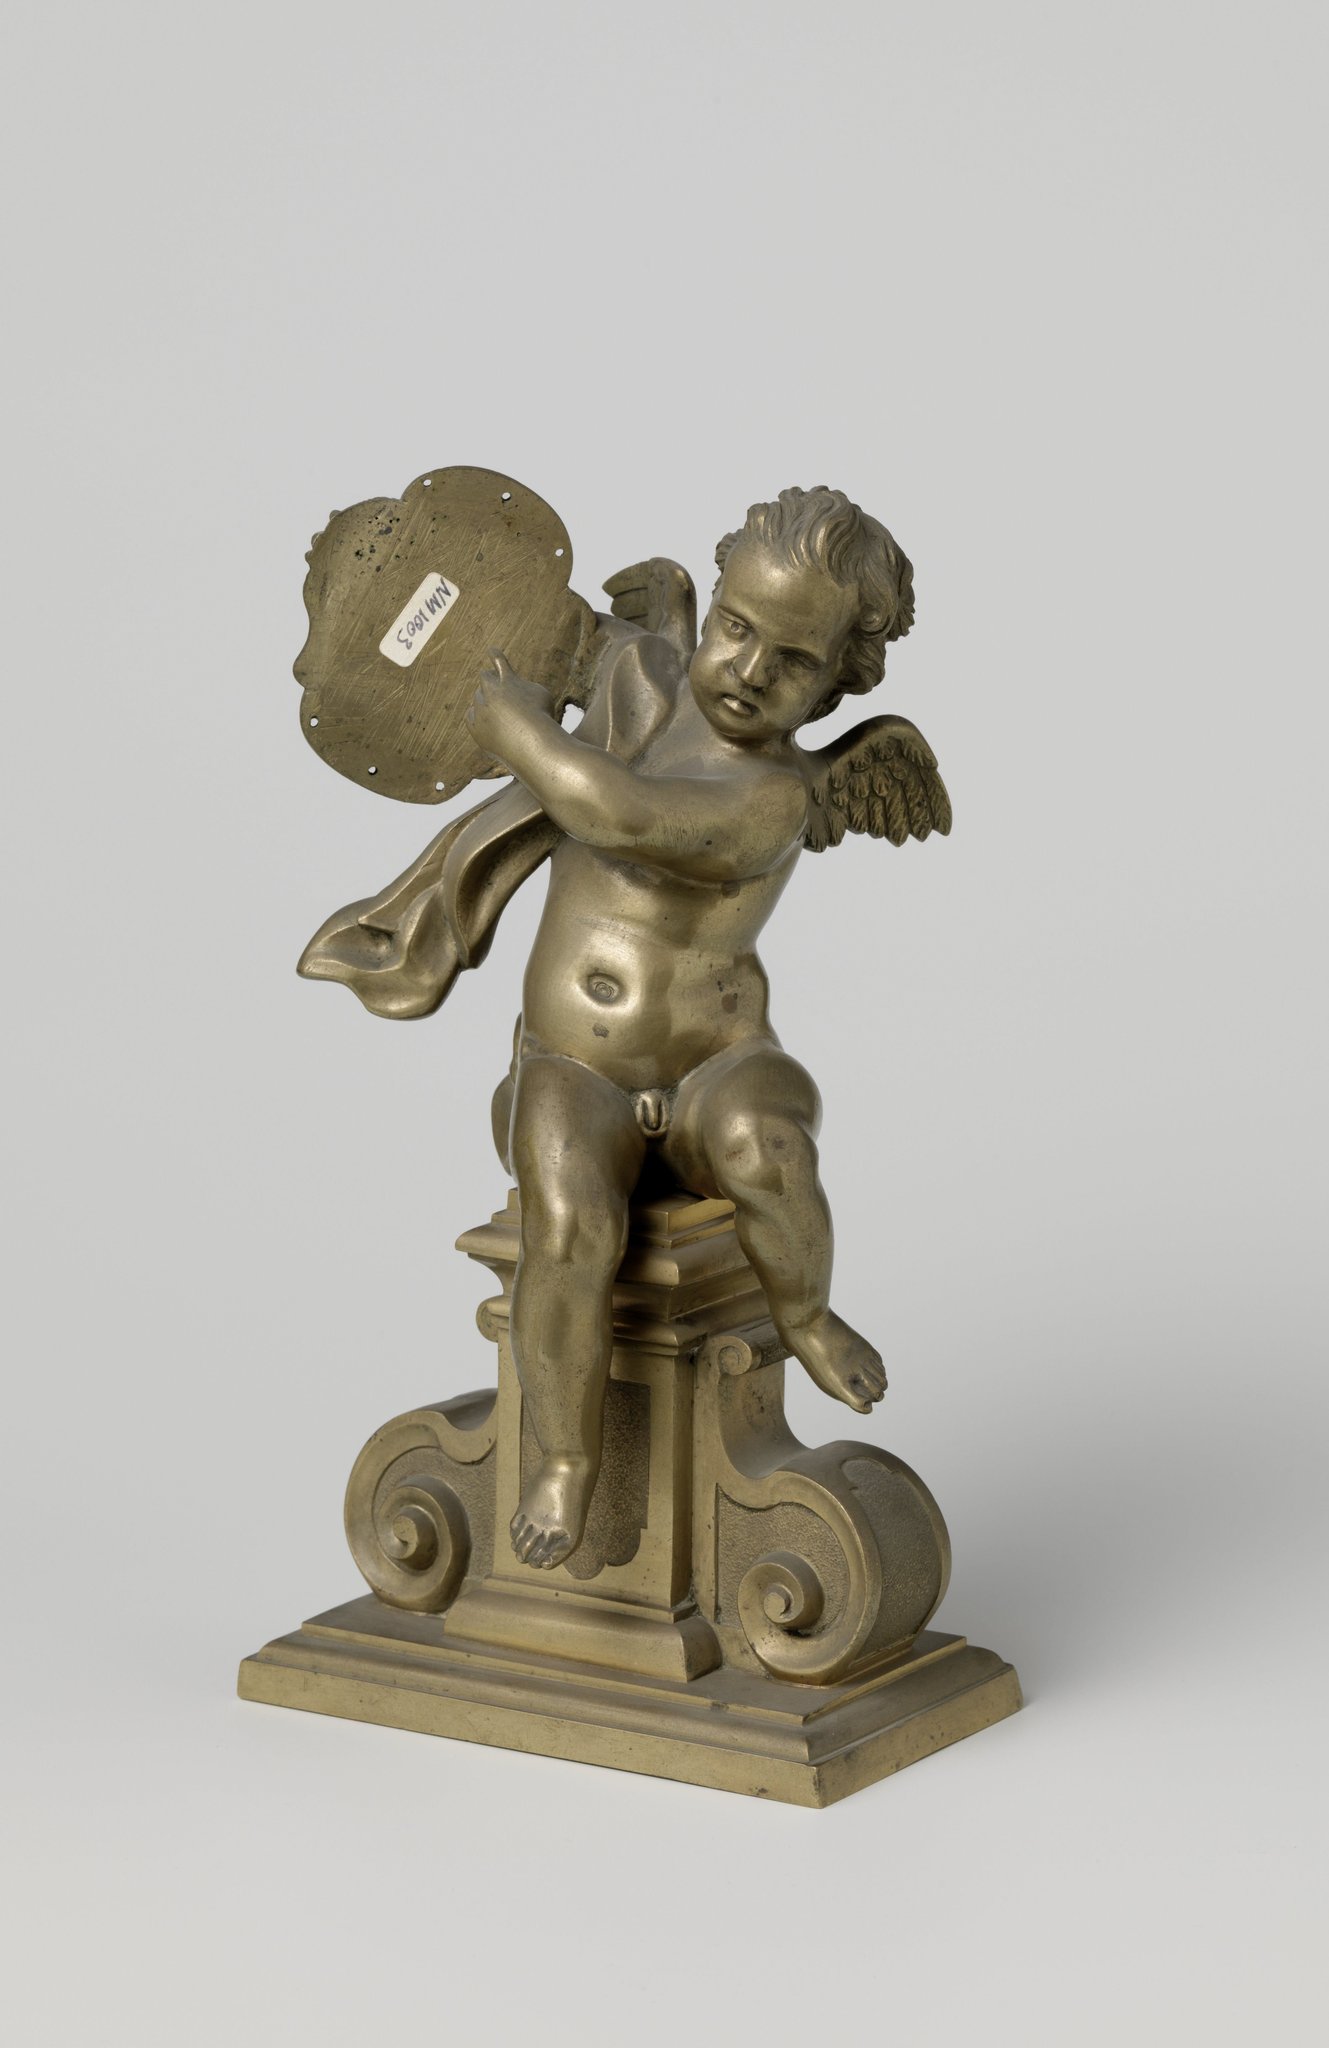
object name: figure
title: Engel op sokkel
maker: Anonymous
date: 1600-1699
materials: brass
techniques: casting, metalworking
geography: southern netherlands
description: Het voorwerp bestaat uit drie gegoten en geciseleerde delen: de sokkel, de engel en de pin, waarmee deze is bevestigd. De geprofileerde sokkel heeft een voetstuk en twee krulelementen aan weerszijden. Het naar beneden kijkende engeltje, dat een draperie over zijn rechterschouder heeft, wijst vermoedelijk naar een wapenschild, waarvan slechts het achterstuk, waarop het gemonteerd was, over is. De engel is met behulp van een houten pijpstuk met een moer vastgeschroefd.